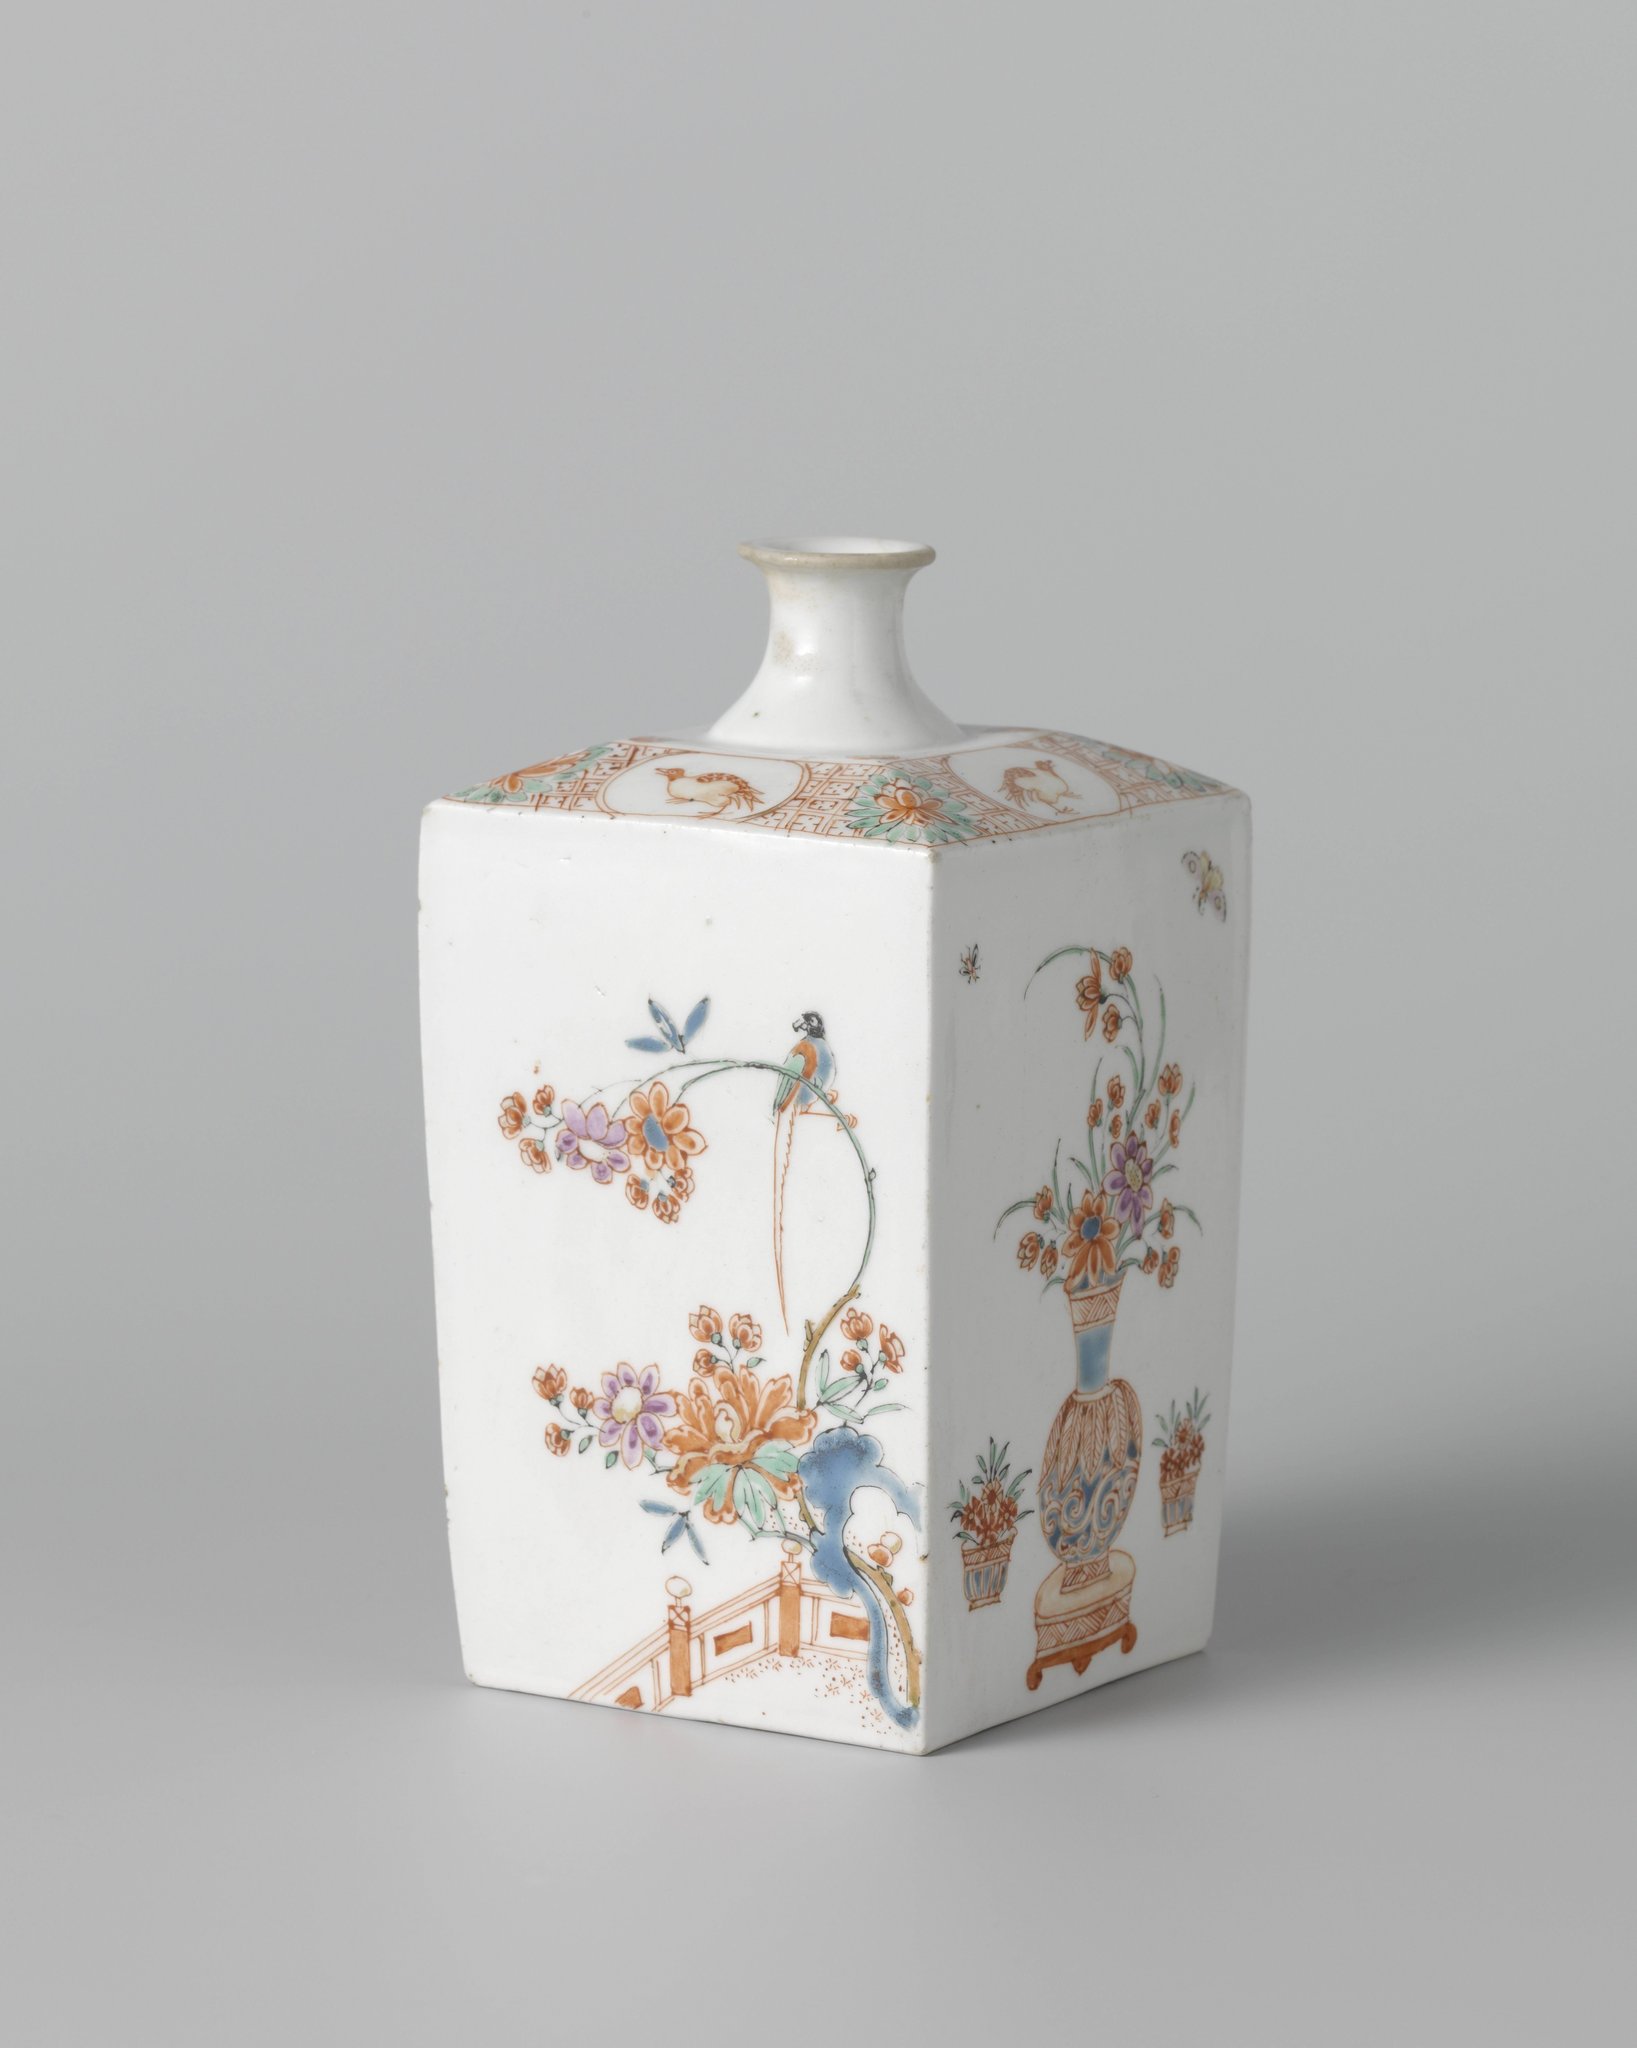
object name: bottle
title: Square bottle with flowering plants, birds, flower vases and insects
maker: Anonymous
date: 1700-1724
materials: glaze, gold, paint, porcelain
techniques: firing, forming, gilding, vitrification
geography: arita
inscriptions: label: ‘Collectie Westendorp/ 141’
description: Pair of square flasks. Japan, c. 1700 - 1720, decorated, c. 1710 - 1725.